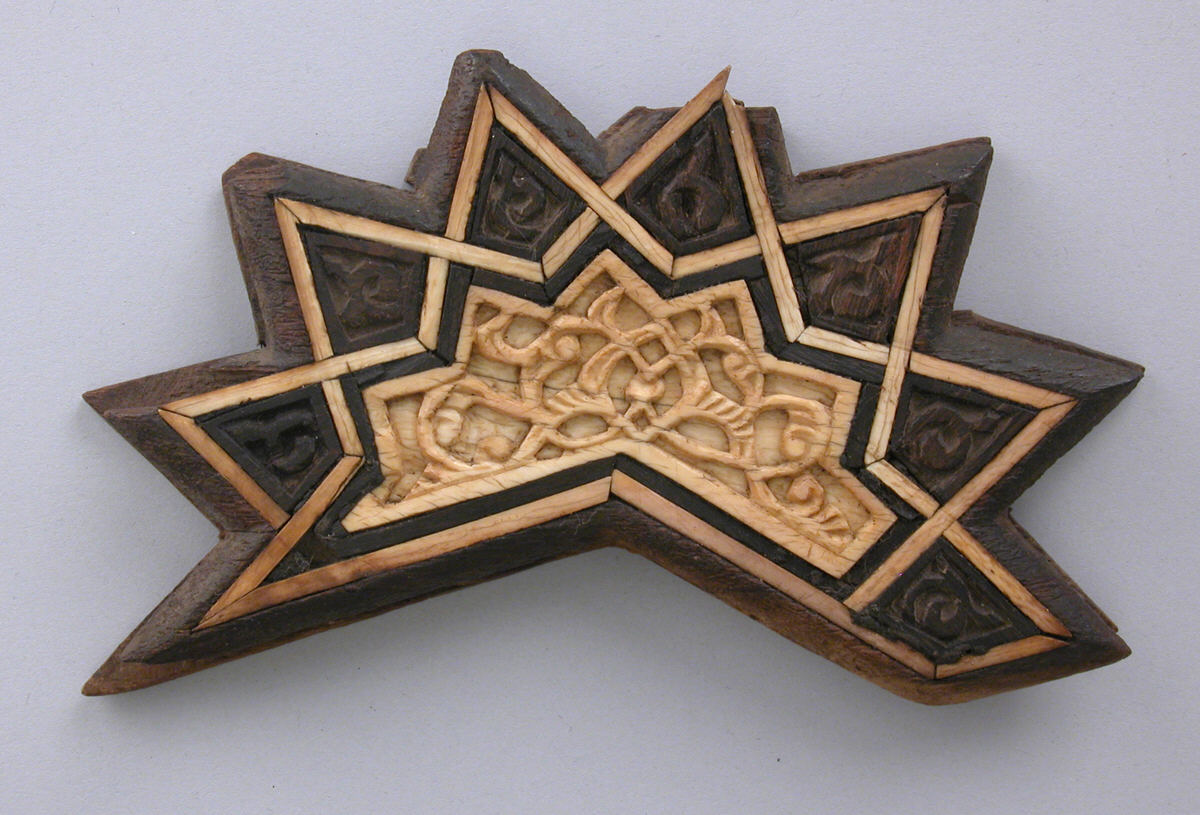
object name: panel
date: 1201-1400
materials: ivory, wood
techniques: carving, inlay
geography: egypt